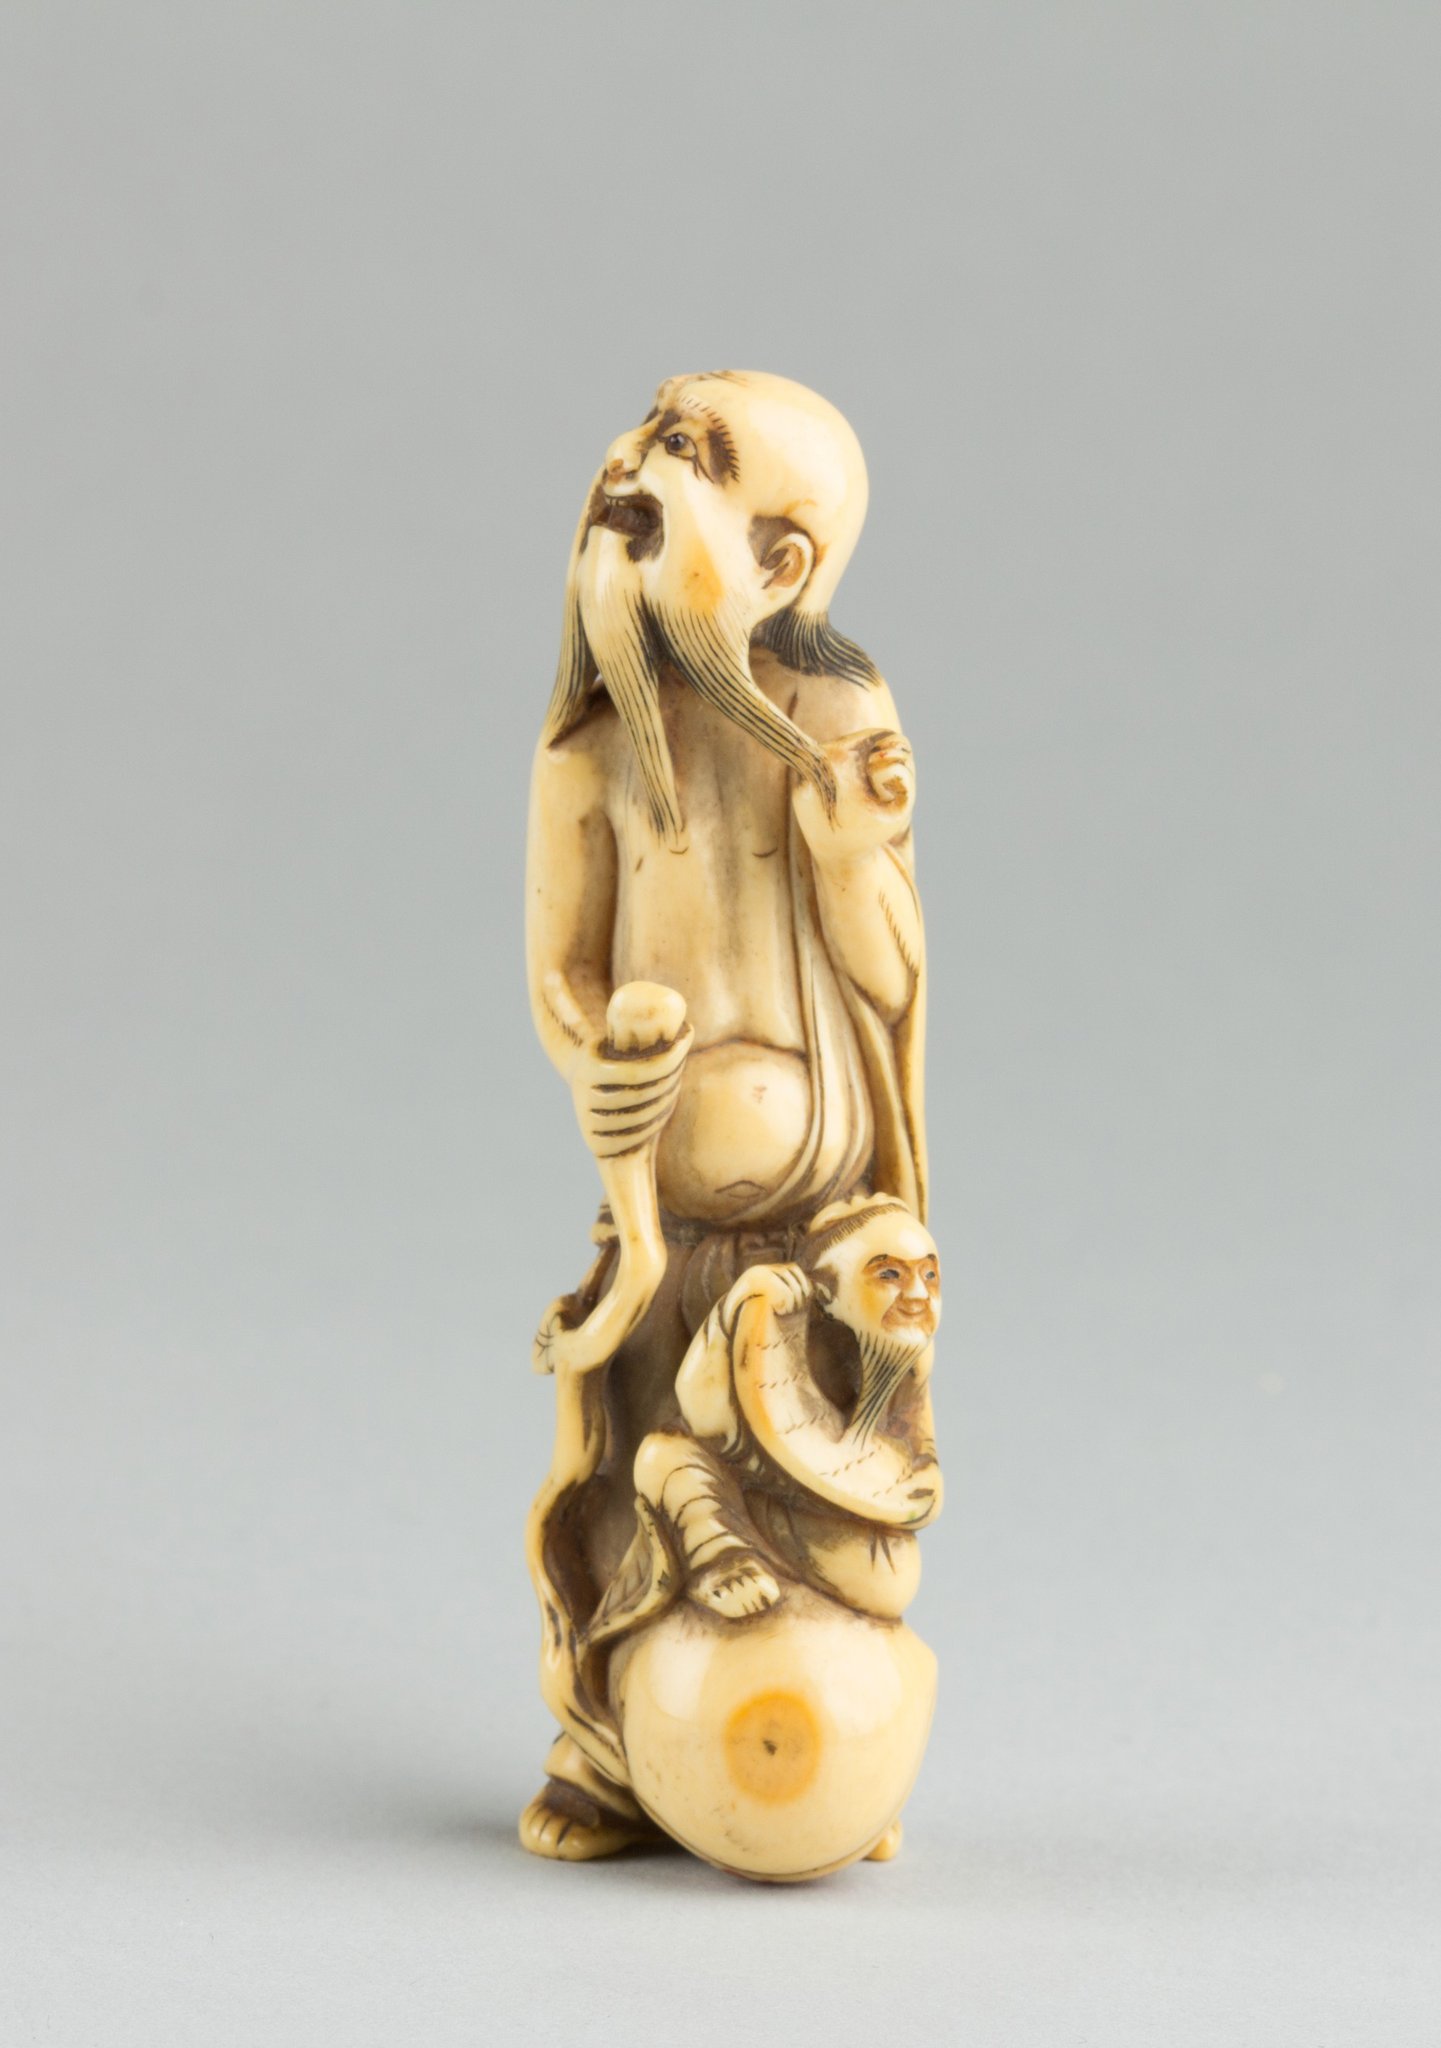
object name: netsuke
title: Netsuke of an Old Man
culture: japanese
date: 1701-1800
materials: ivory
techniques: inlay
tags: men